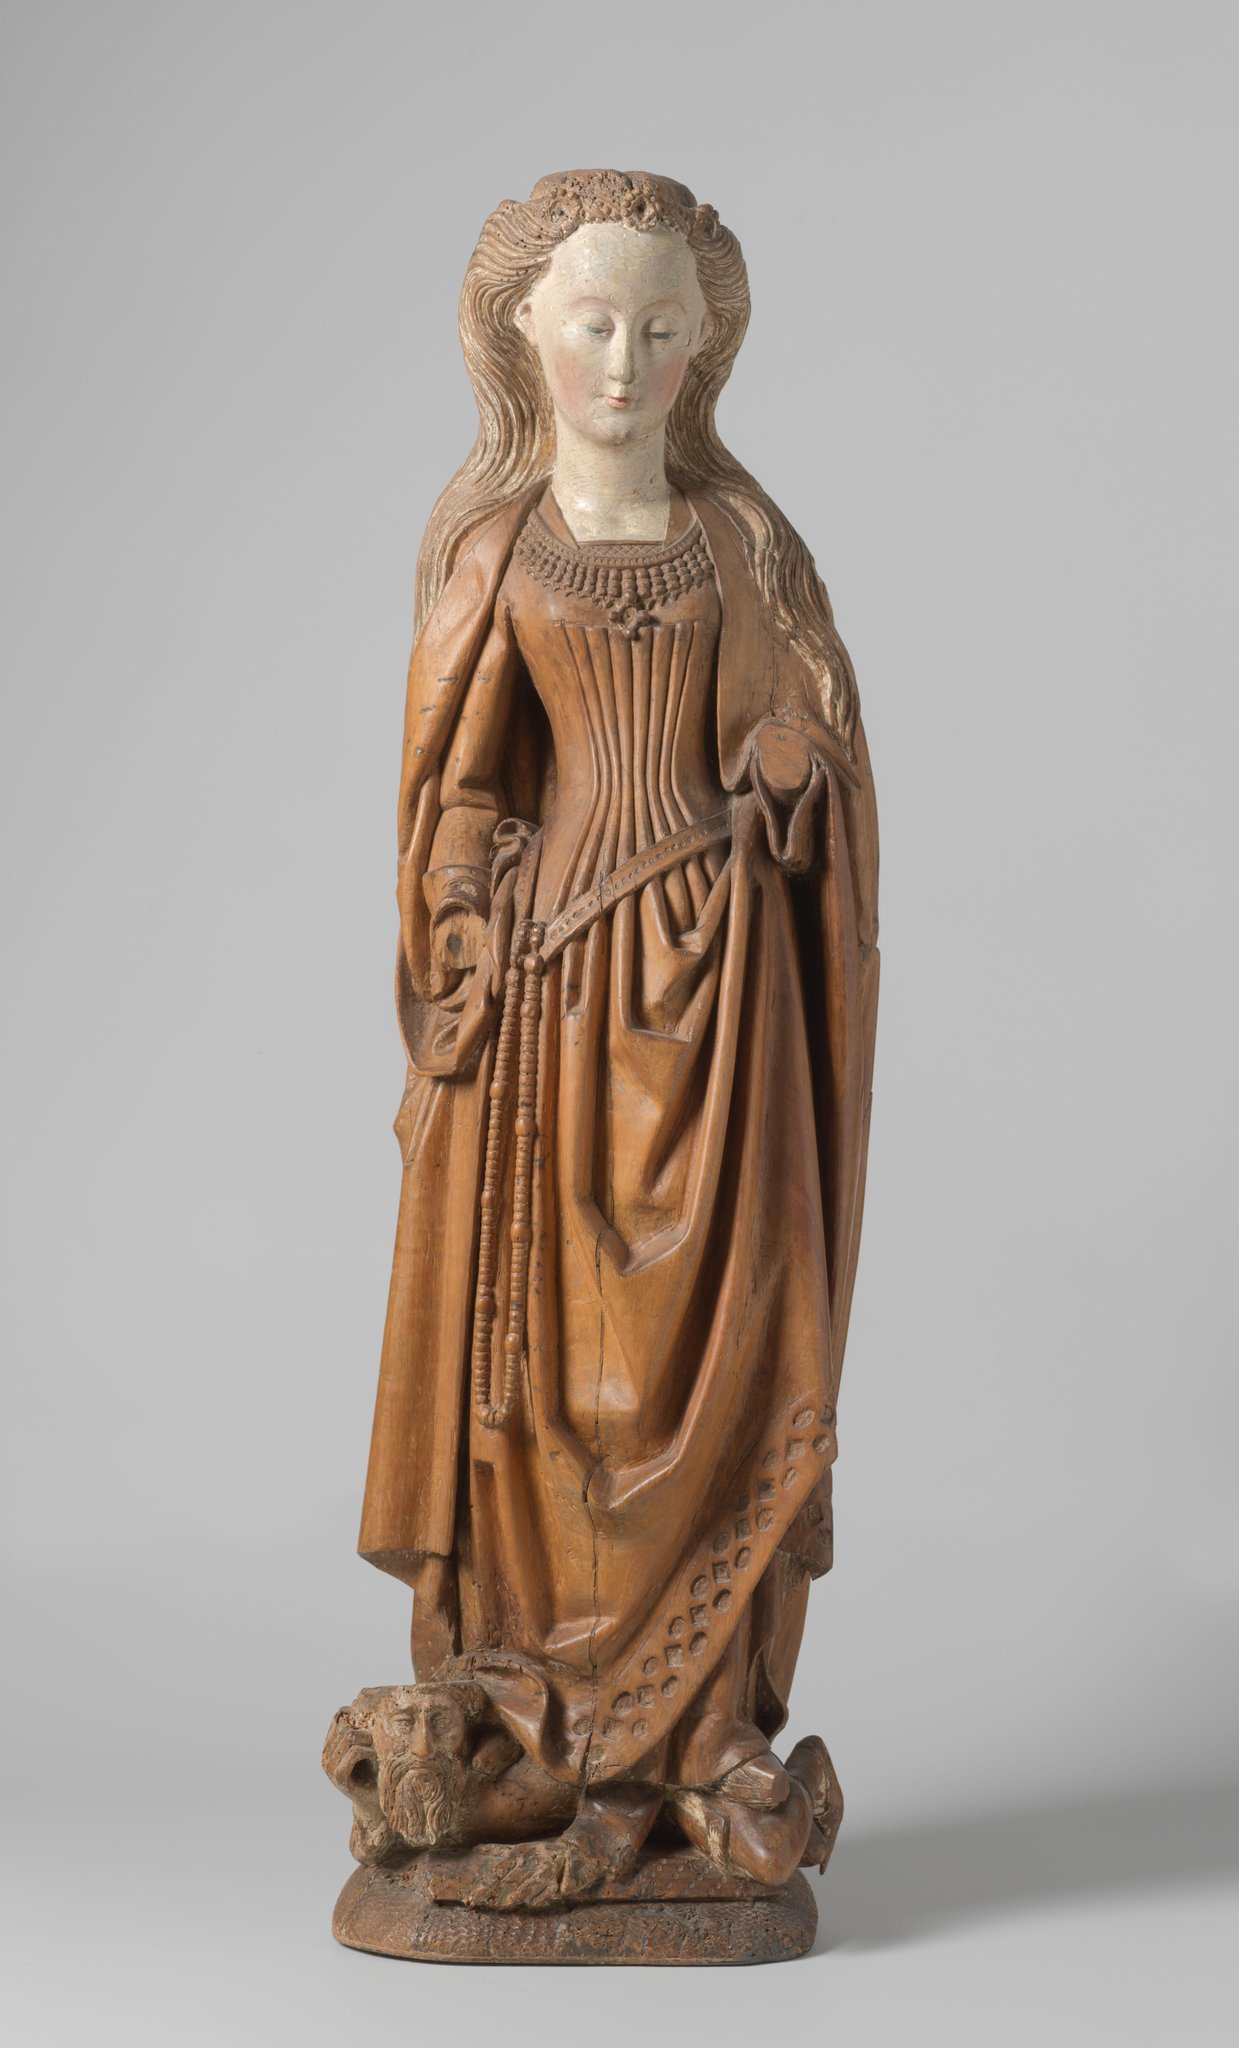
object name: sculpture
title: St Catherine of Alexandria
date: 1470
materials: wood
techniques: polychromy